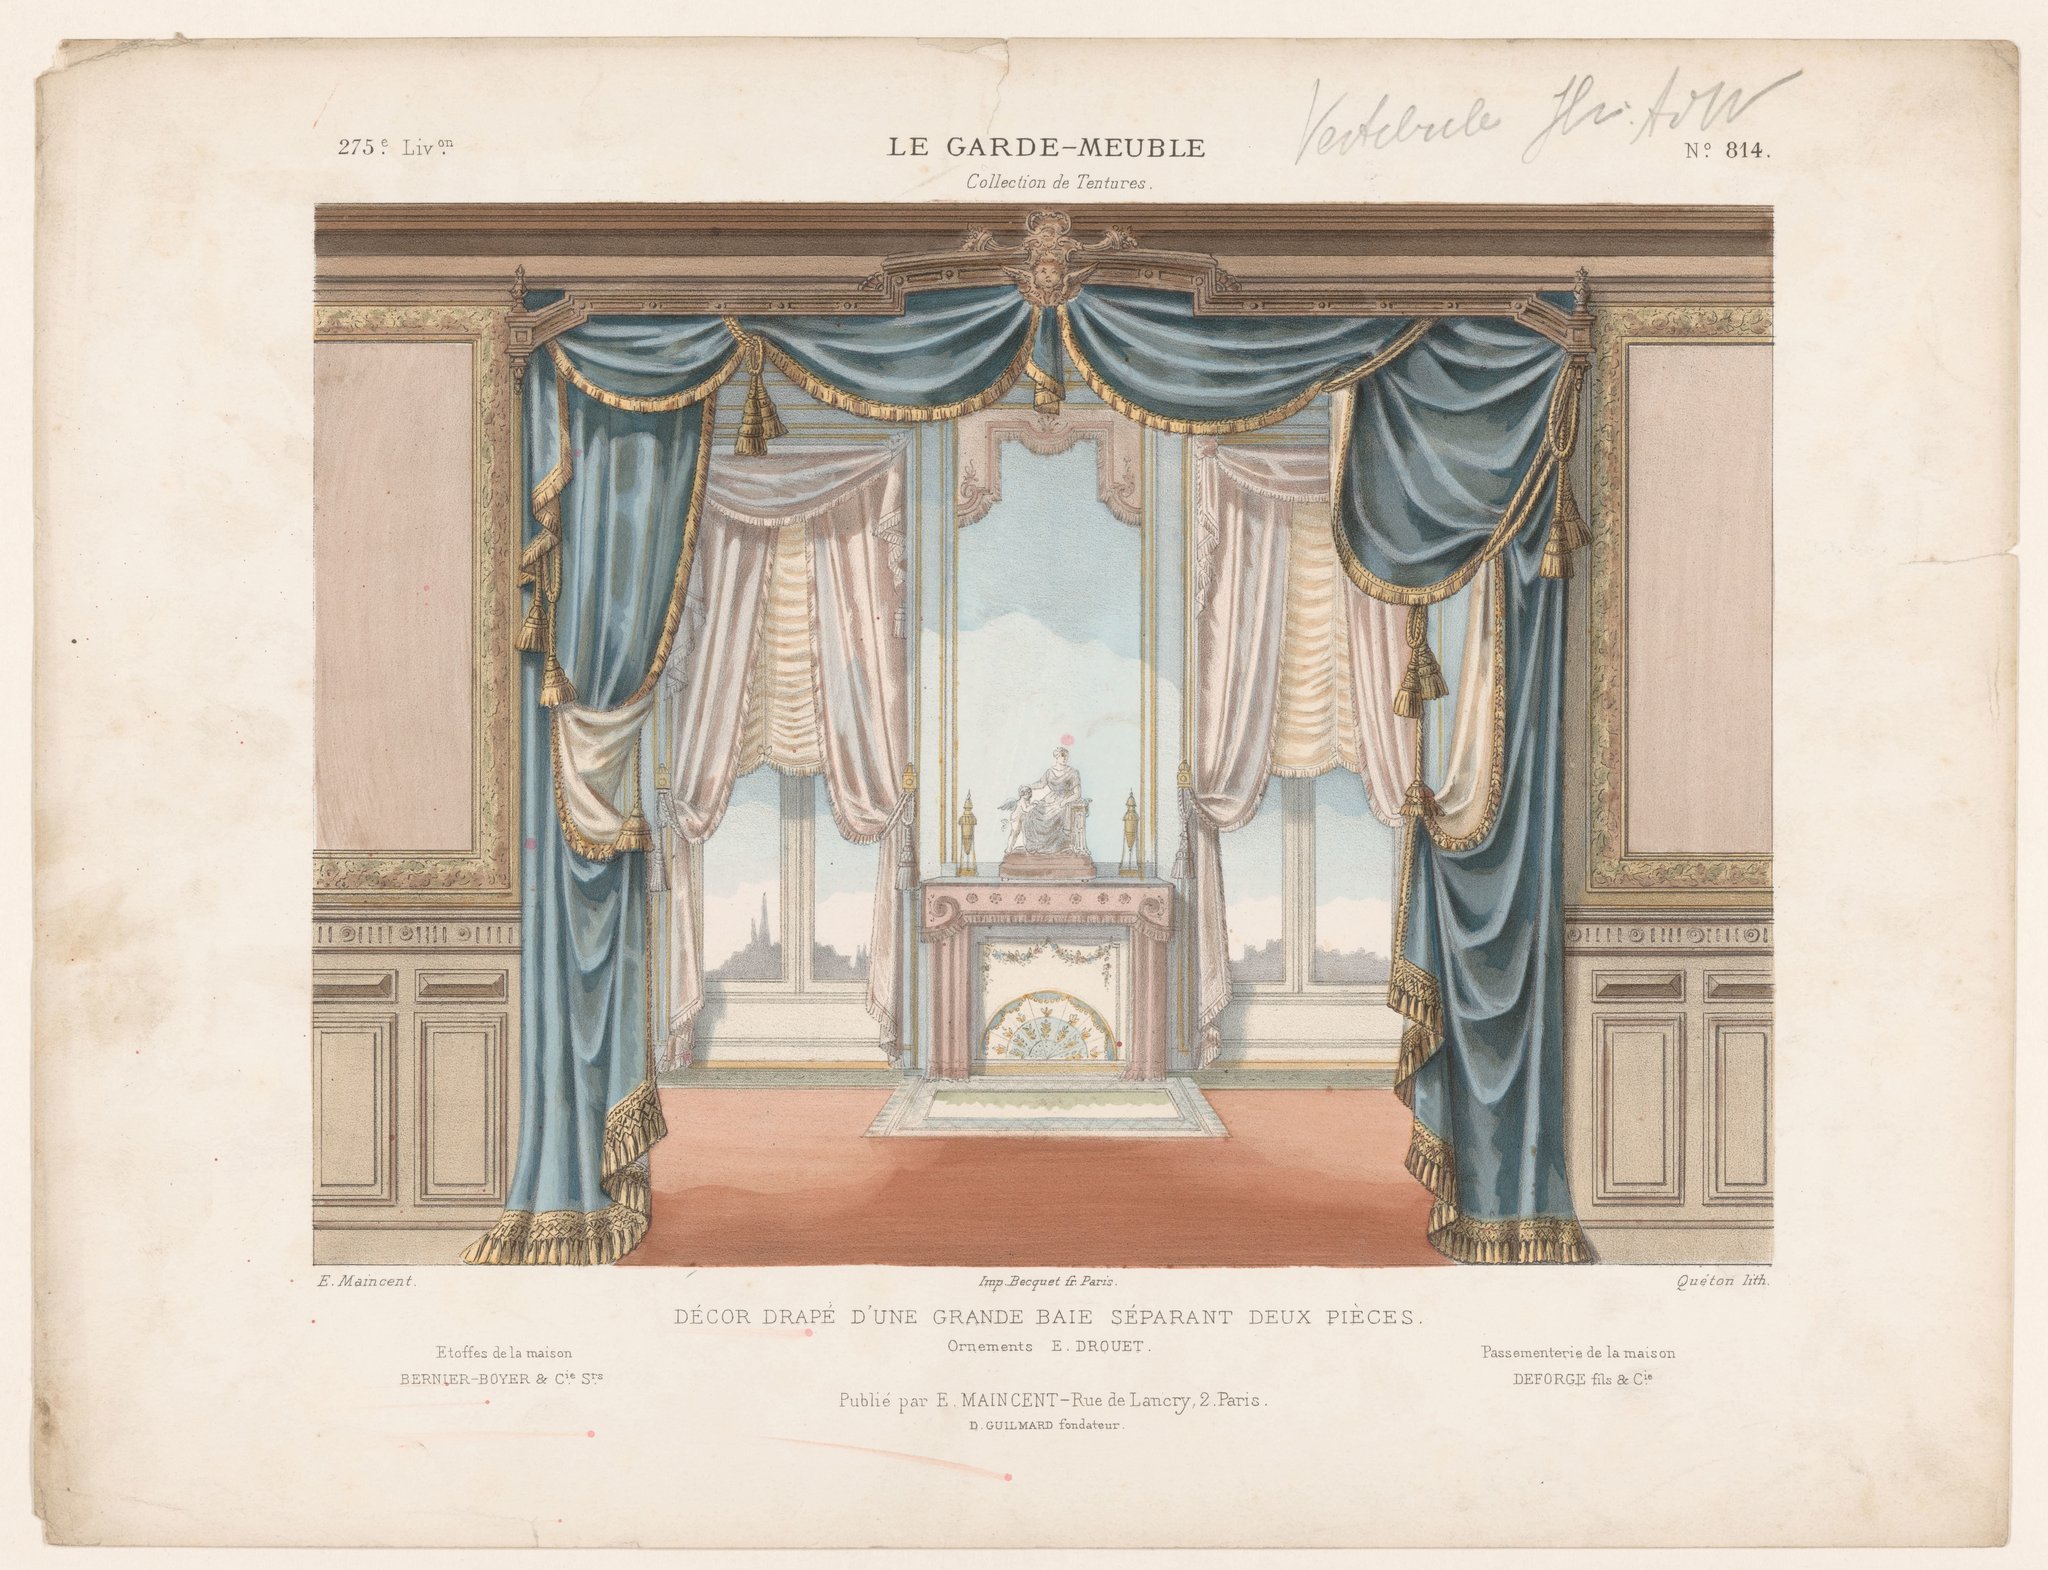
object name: print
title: Décor drapé d'une Grande Baie séparant deux Pièces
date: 1885-1895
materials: paper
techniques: hand coloring, lithograph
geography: paris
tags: door, hangings and drapery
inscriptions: annotation: ‘Vestibule [...]’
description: Grote doorgang met gedrapeerde gordijnen tussen twee vertrekken. Prent uit 275e Livraison.